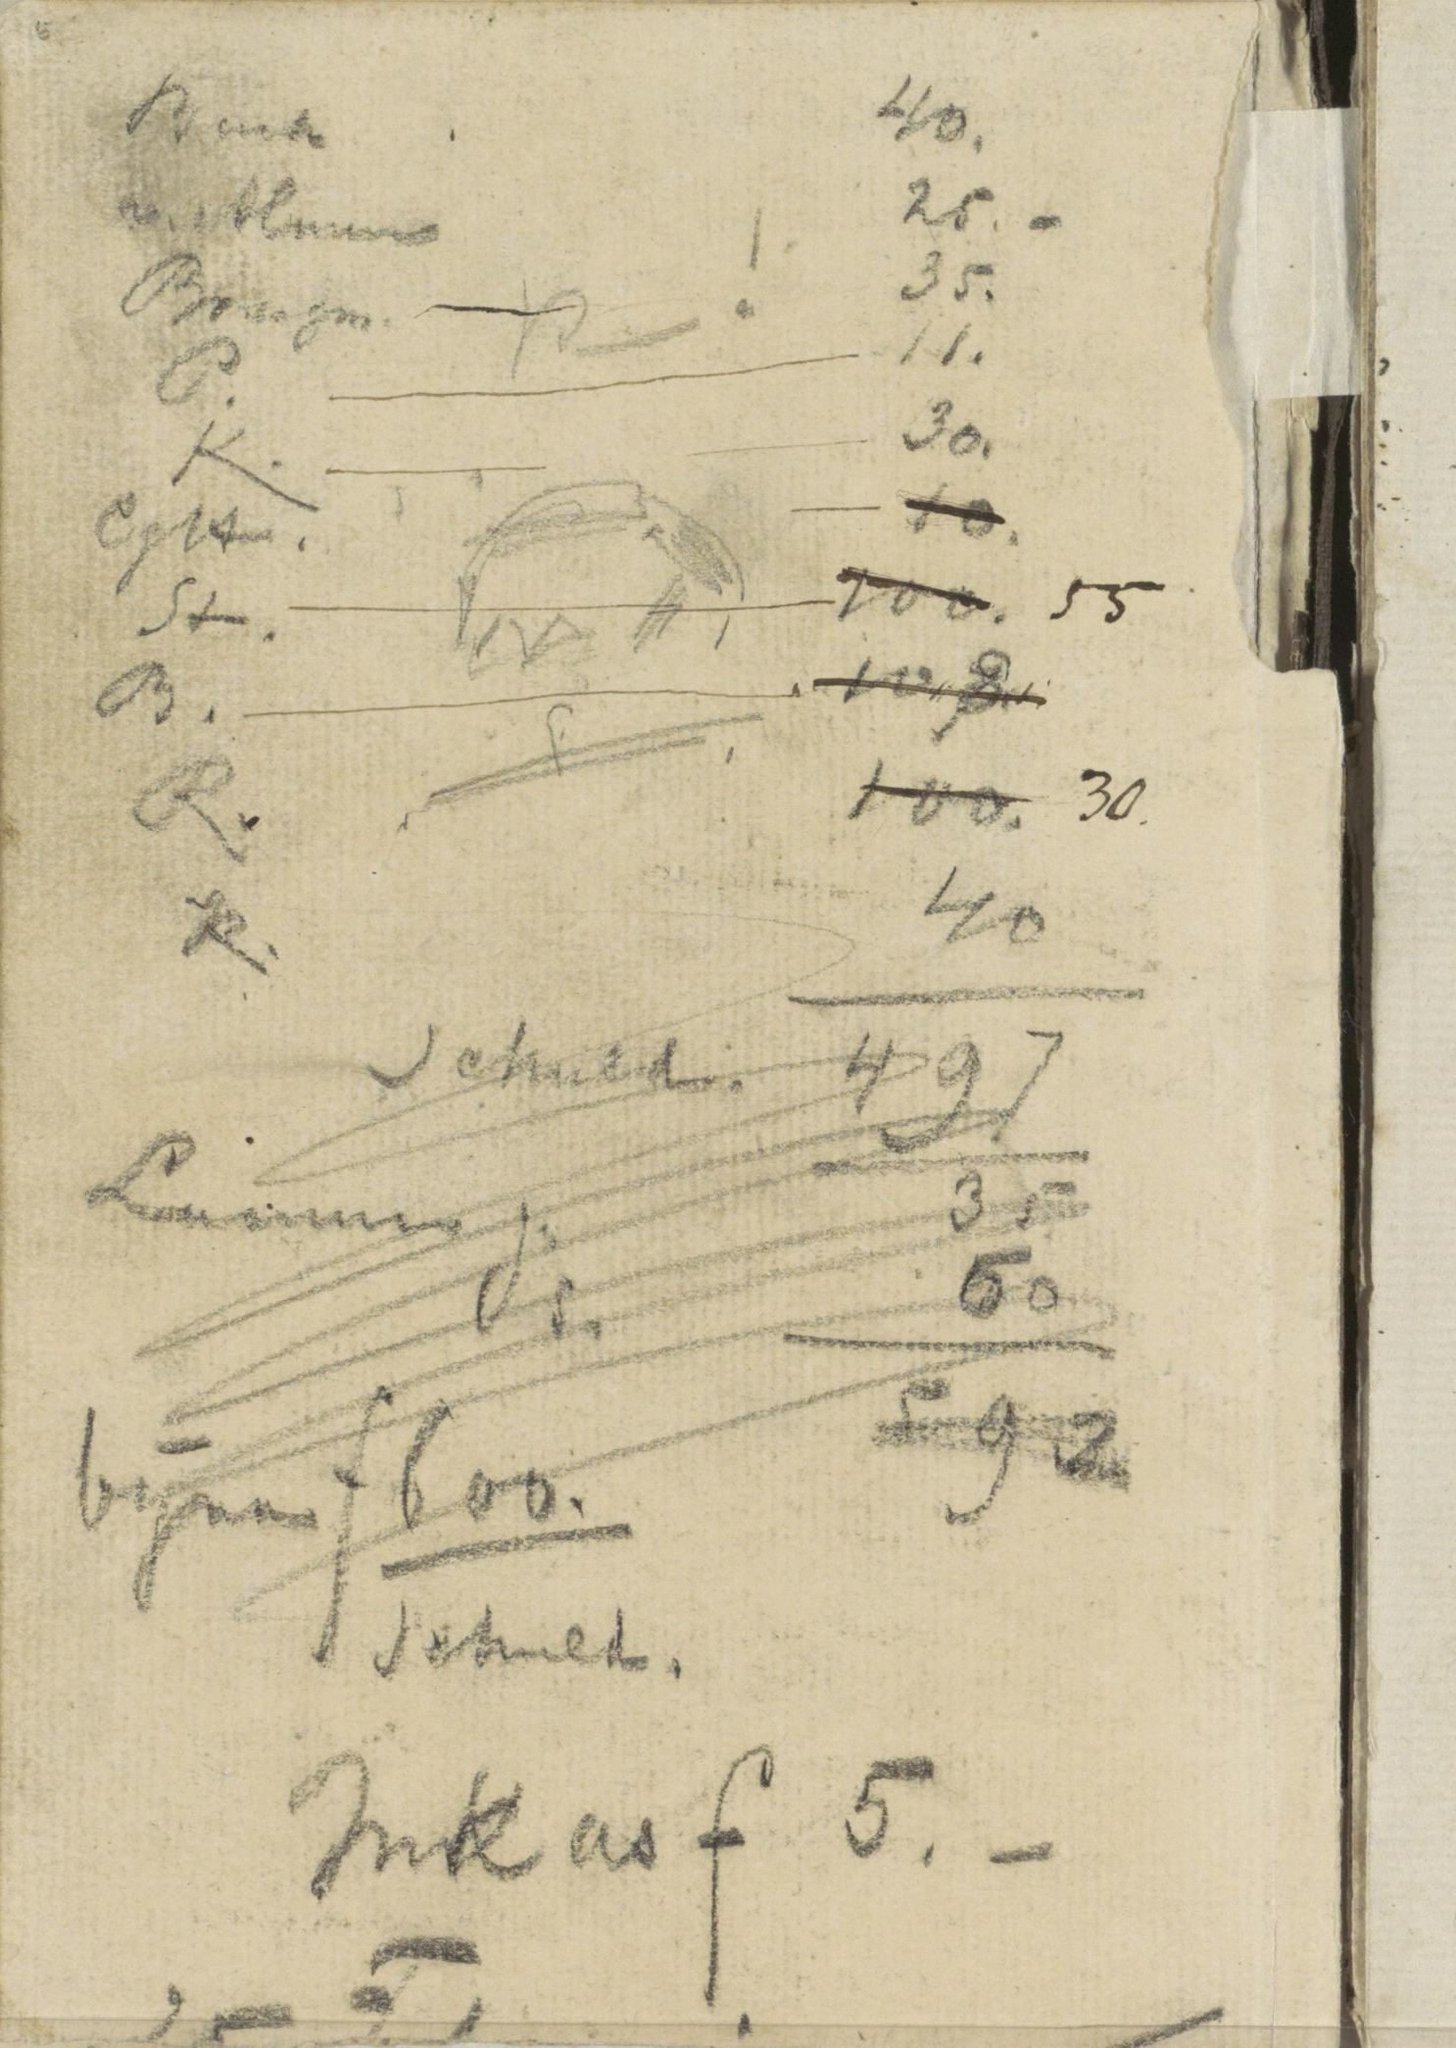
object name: sketchbook leaf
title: Bedragen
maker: george hendrik breitner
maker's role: draughtsman, painter, print maker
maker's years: 1857-1923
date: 1881-1883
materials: chalk, paper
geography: the hague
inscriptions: annotation: ‘[...]’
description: Pagina 5 uit een schetsboek met 9 bladen.